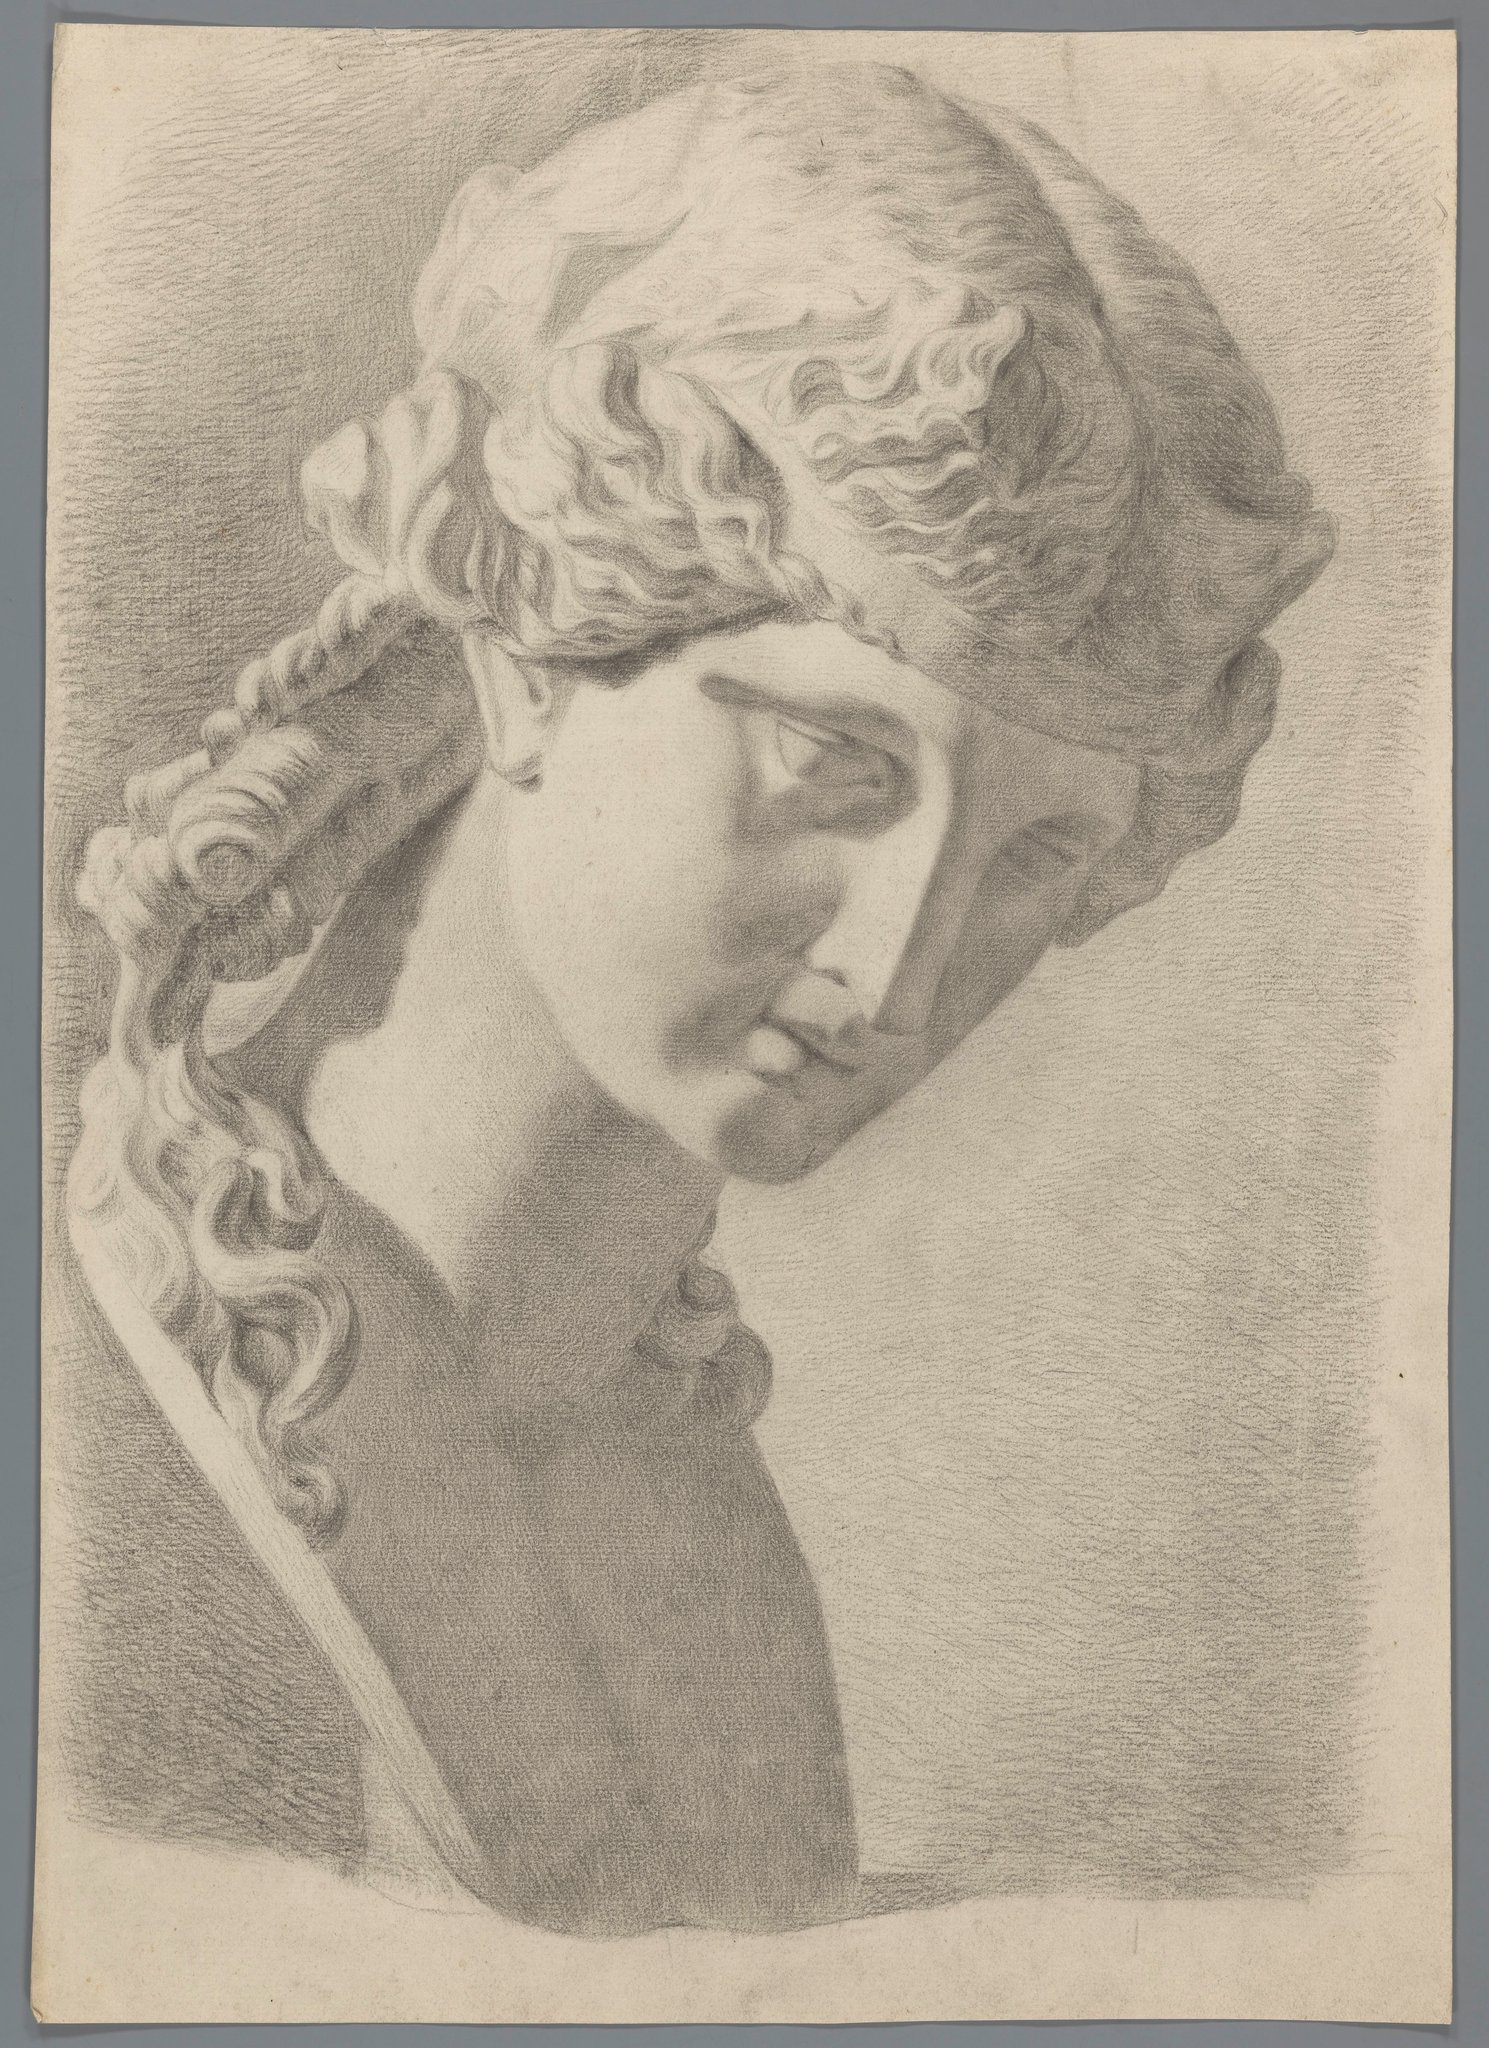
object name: drawing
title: Studie naar een klassieke kop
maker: gerard allebé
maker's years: 1849-1879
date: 1811-1826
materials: chalk, paper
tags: head (human), piece of sculpture, reproduction of a piece of sculpture